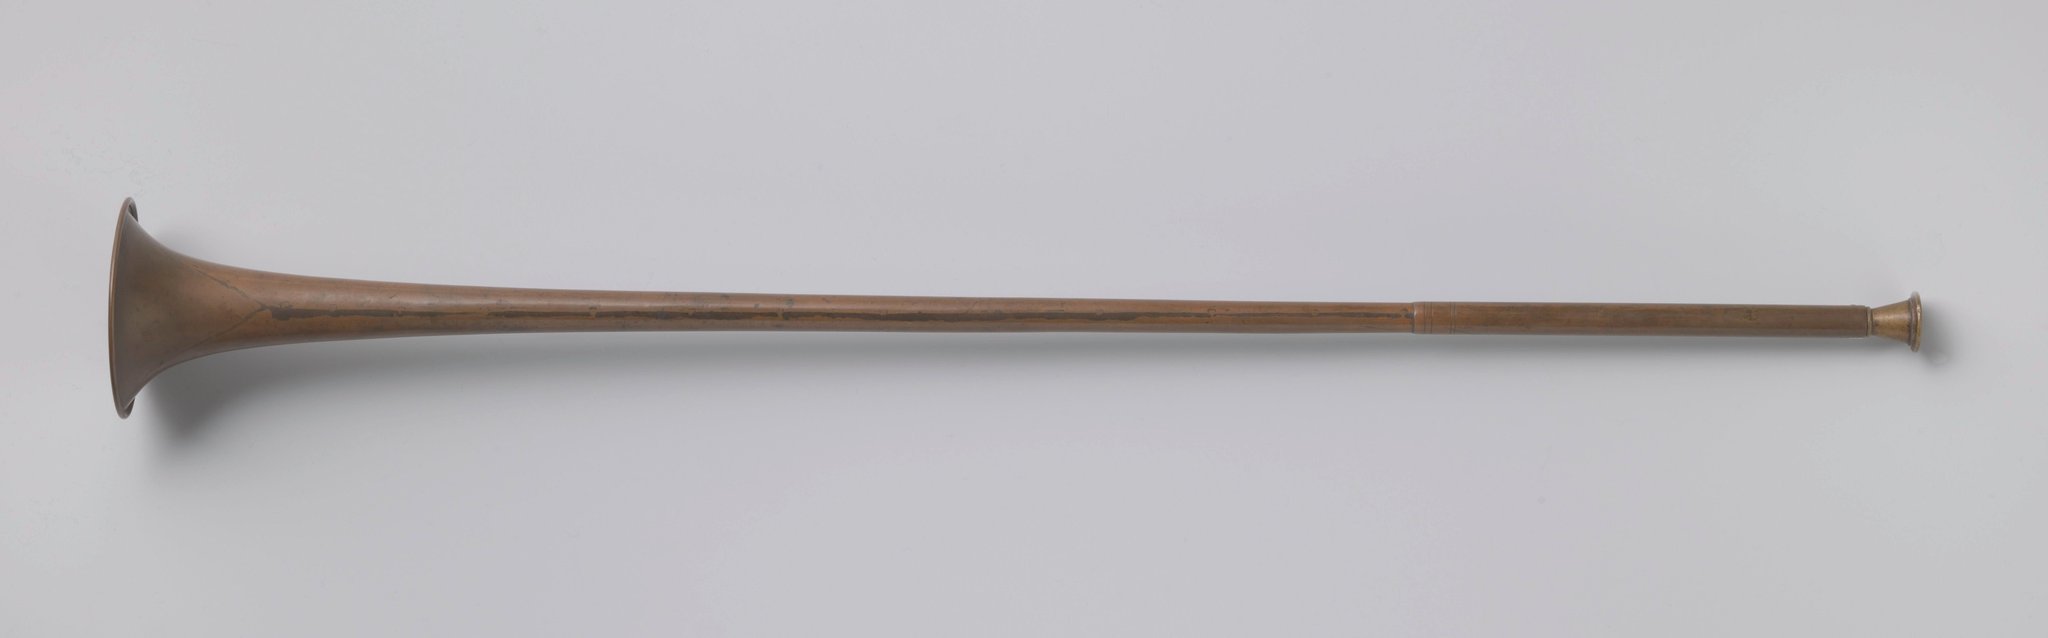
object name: musical instrument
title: Fanfare trumpet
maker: Anonymous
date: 1850-1896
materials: copper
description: Fanfaretrompet van messing. Langgestrekt model met vastgelast mondstuk.